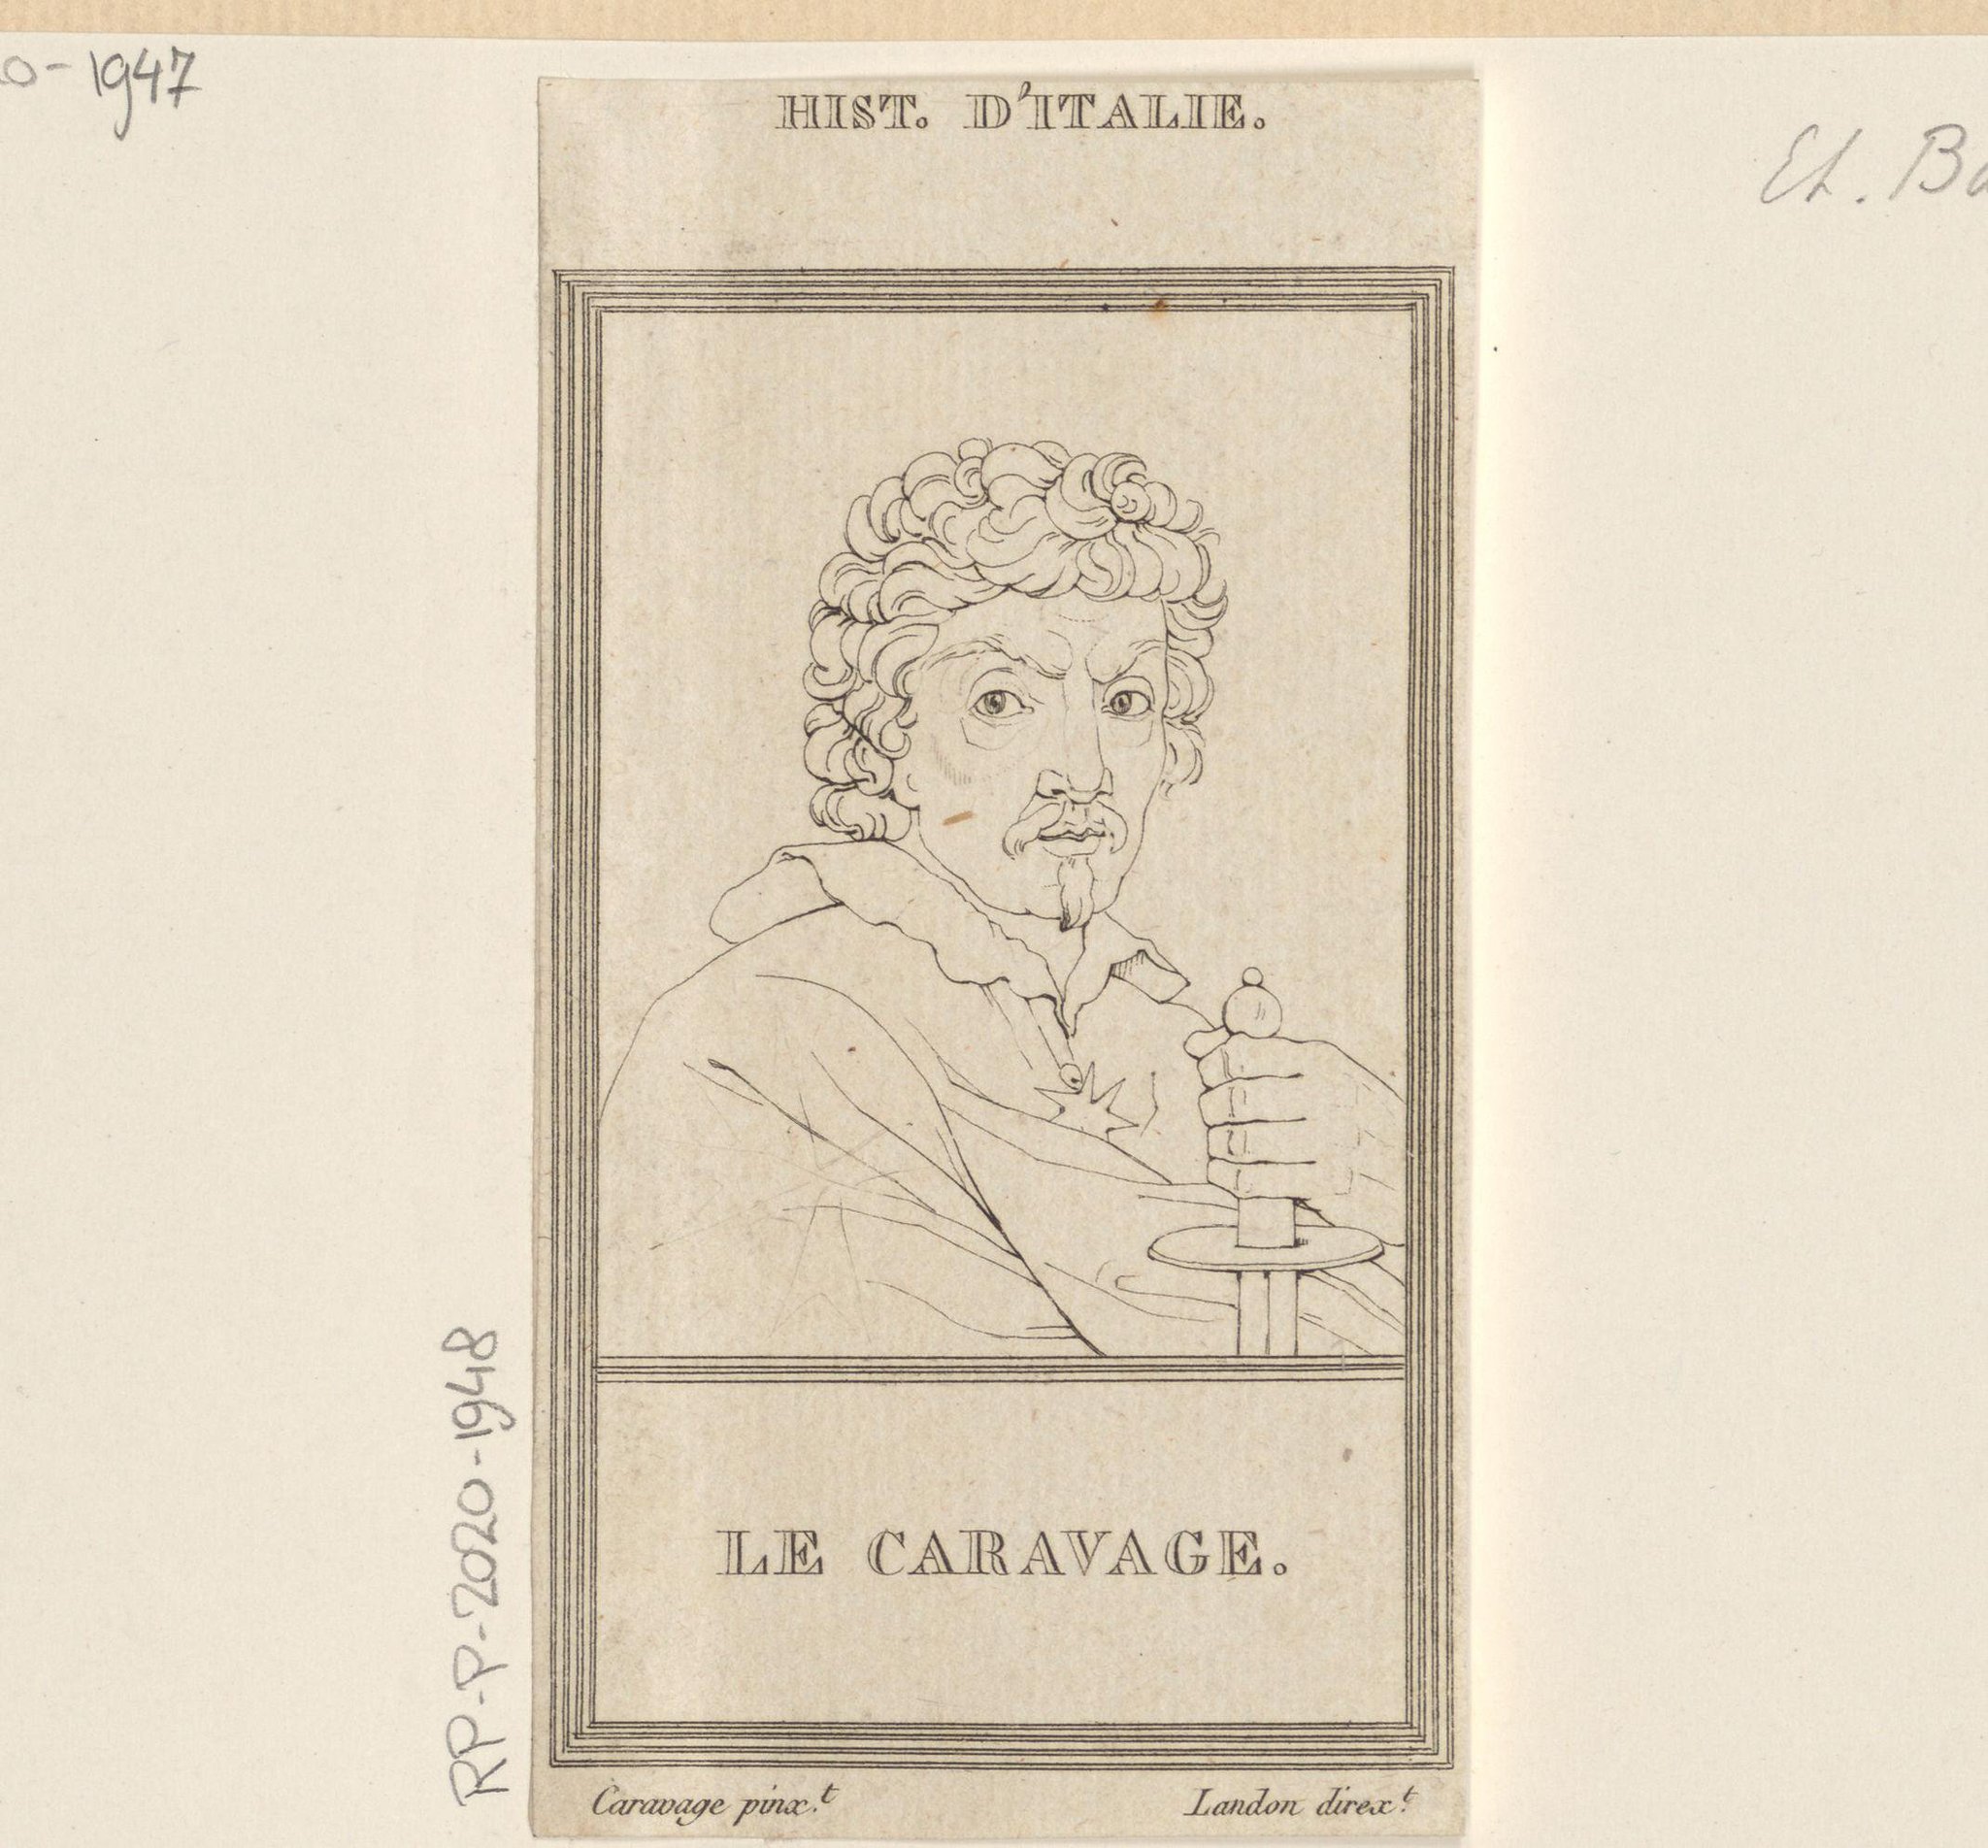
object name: print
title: Portret van Caravaggio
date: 1805-1811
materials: paper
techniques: engraving, etching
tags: painter, caravaggio, historical persons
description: Prent waarschijnlijk uit: Galerie historique des hommes les plus célèbres (...). Parijs: Charles Paul Landon, 1805-1811.